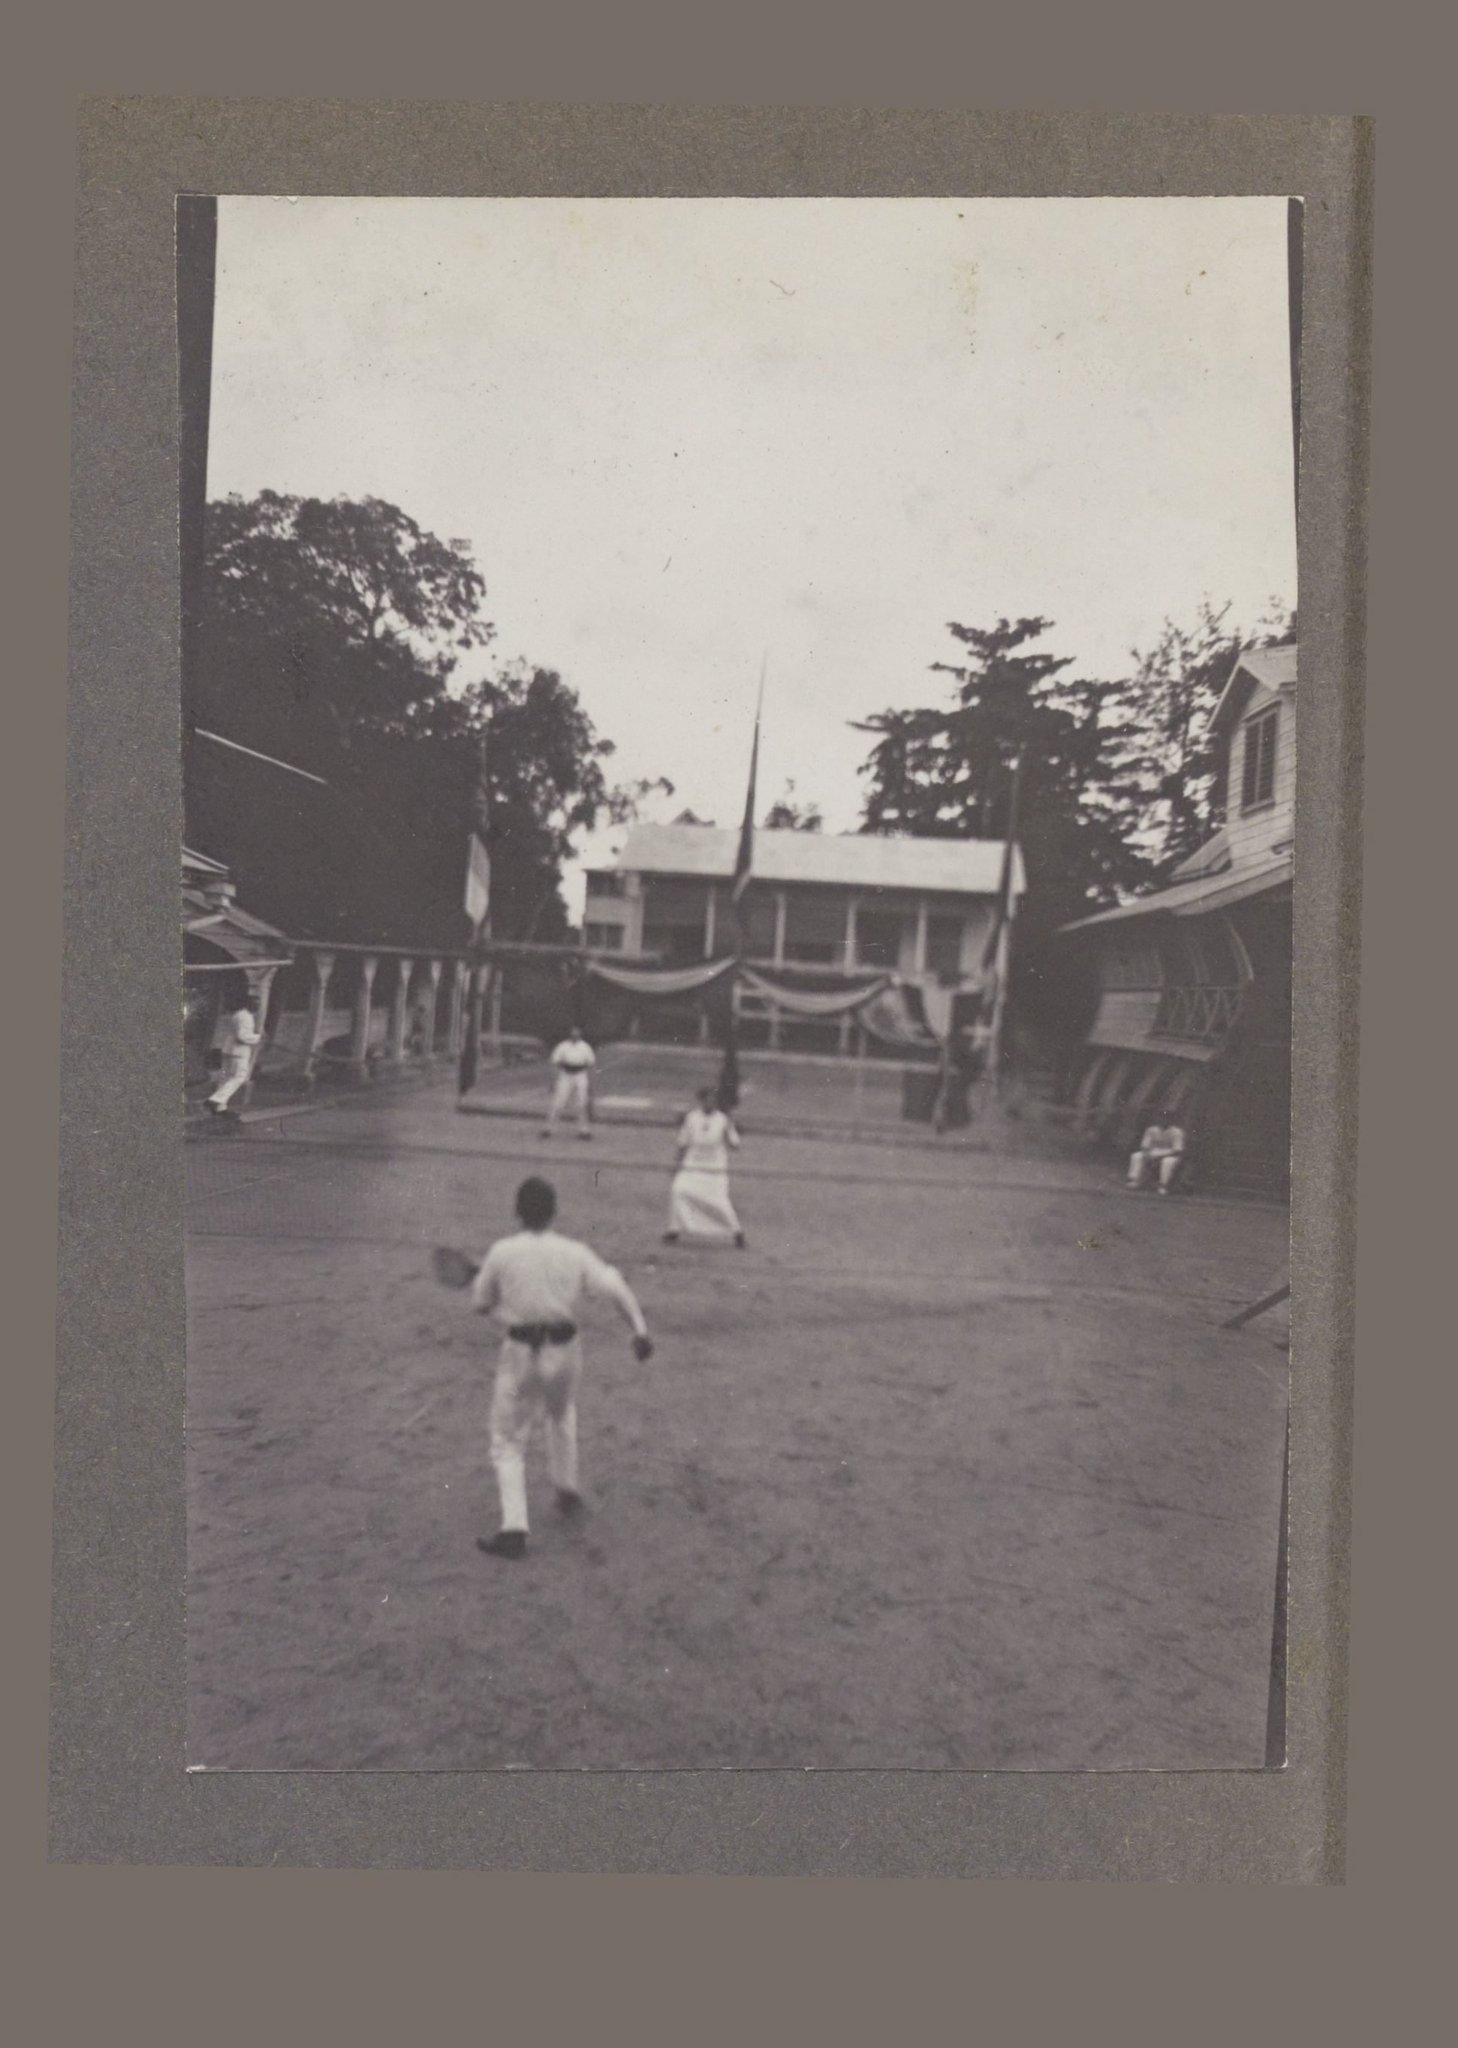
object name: photograph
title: Tennismatch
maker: Anonymous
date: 1907-1912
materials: photographic support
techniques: photography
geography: paramaribo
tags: tennis, lawn-tennis, suriname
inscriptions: inscription: ‘Tennismatch met de officieren van Hr Ms "Zeeland" Juli 1912’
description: Tenniswedstrijd met de officieren van het Pantserdekschip Hr. Ms. Zeeland op de tennisclub in Paramaribo, juli 1912. Onderdeel van het fotoalbum over het leven van de familie Gonggrijp in Suriname rond 1912.